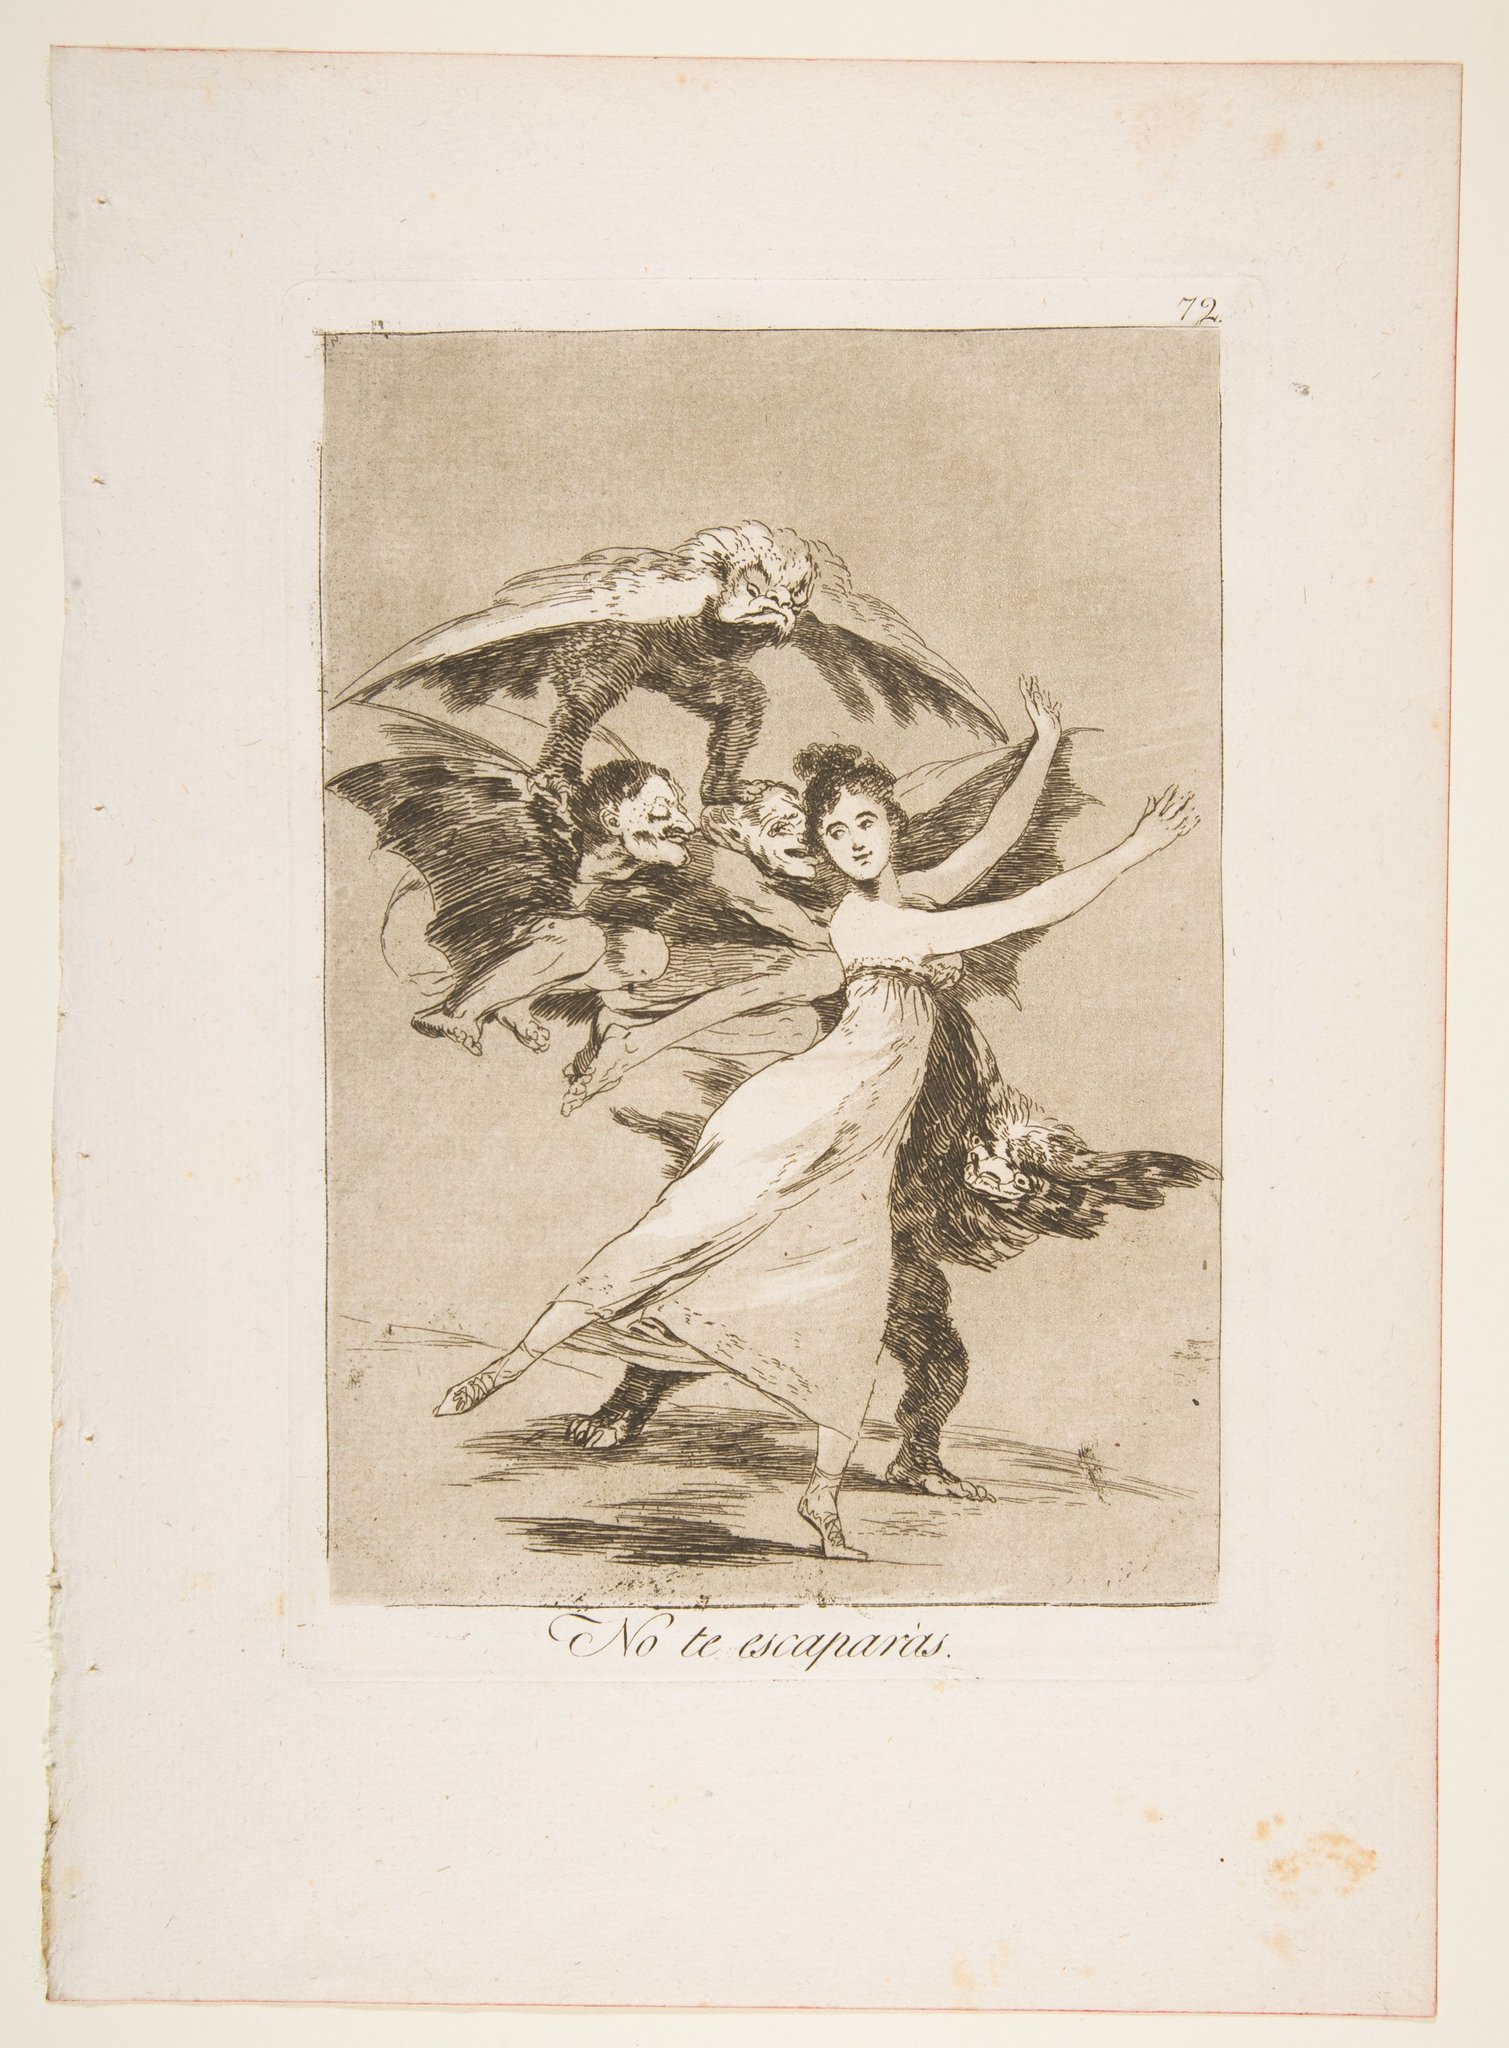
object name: print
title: Plate 72 from "Los Caprichos": You will not escape (No te escaparàs)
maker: goya (francisco de goya y lucientes)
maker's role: artist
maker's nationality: spanish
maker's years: 1746-1828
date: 1799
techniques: aquatint, burnishing, etching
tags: women